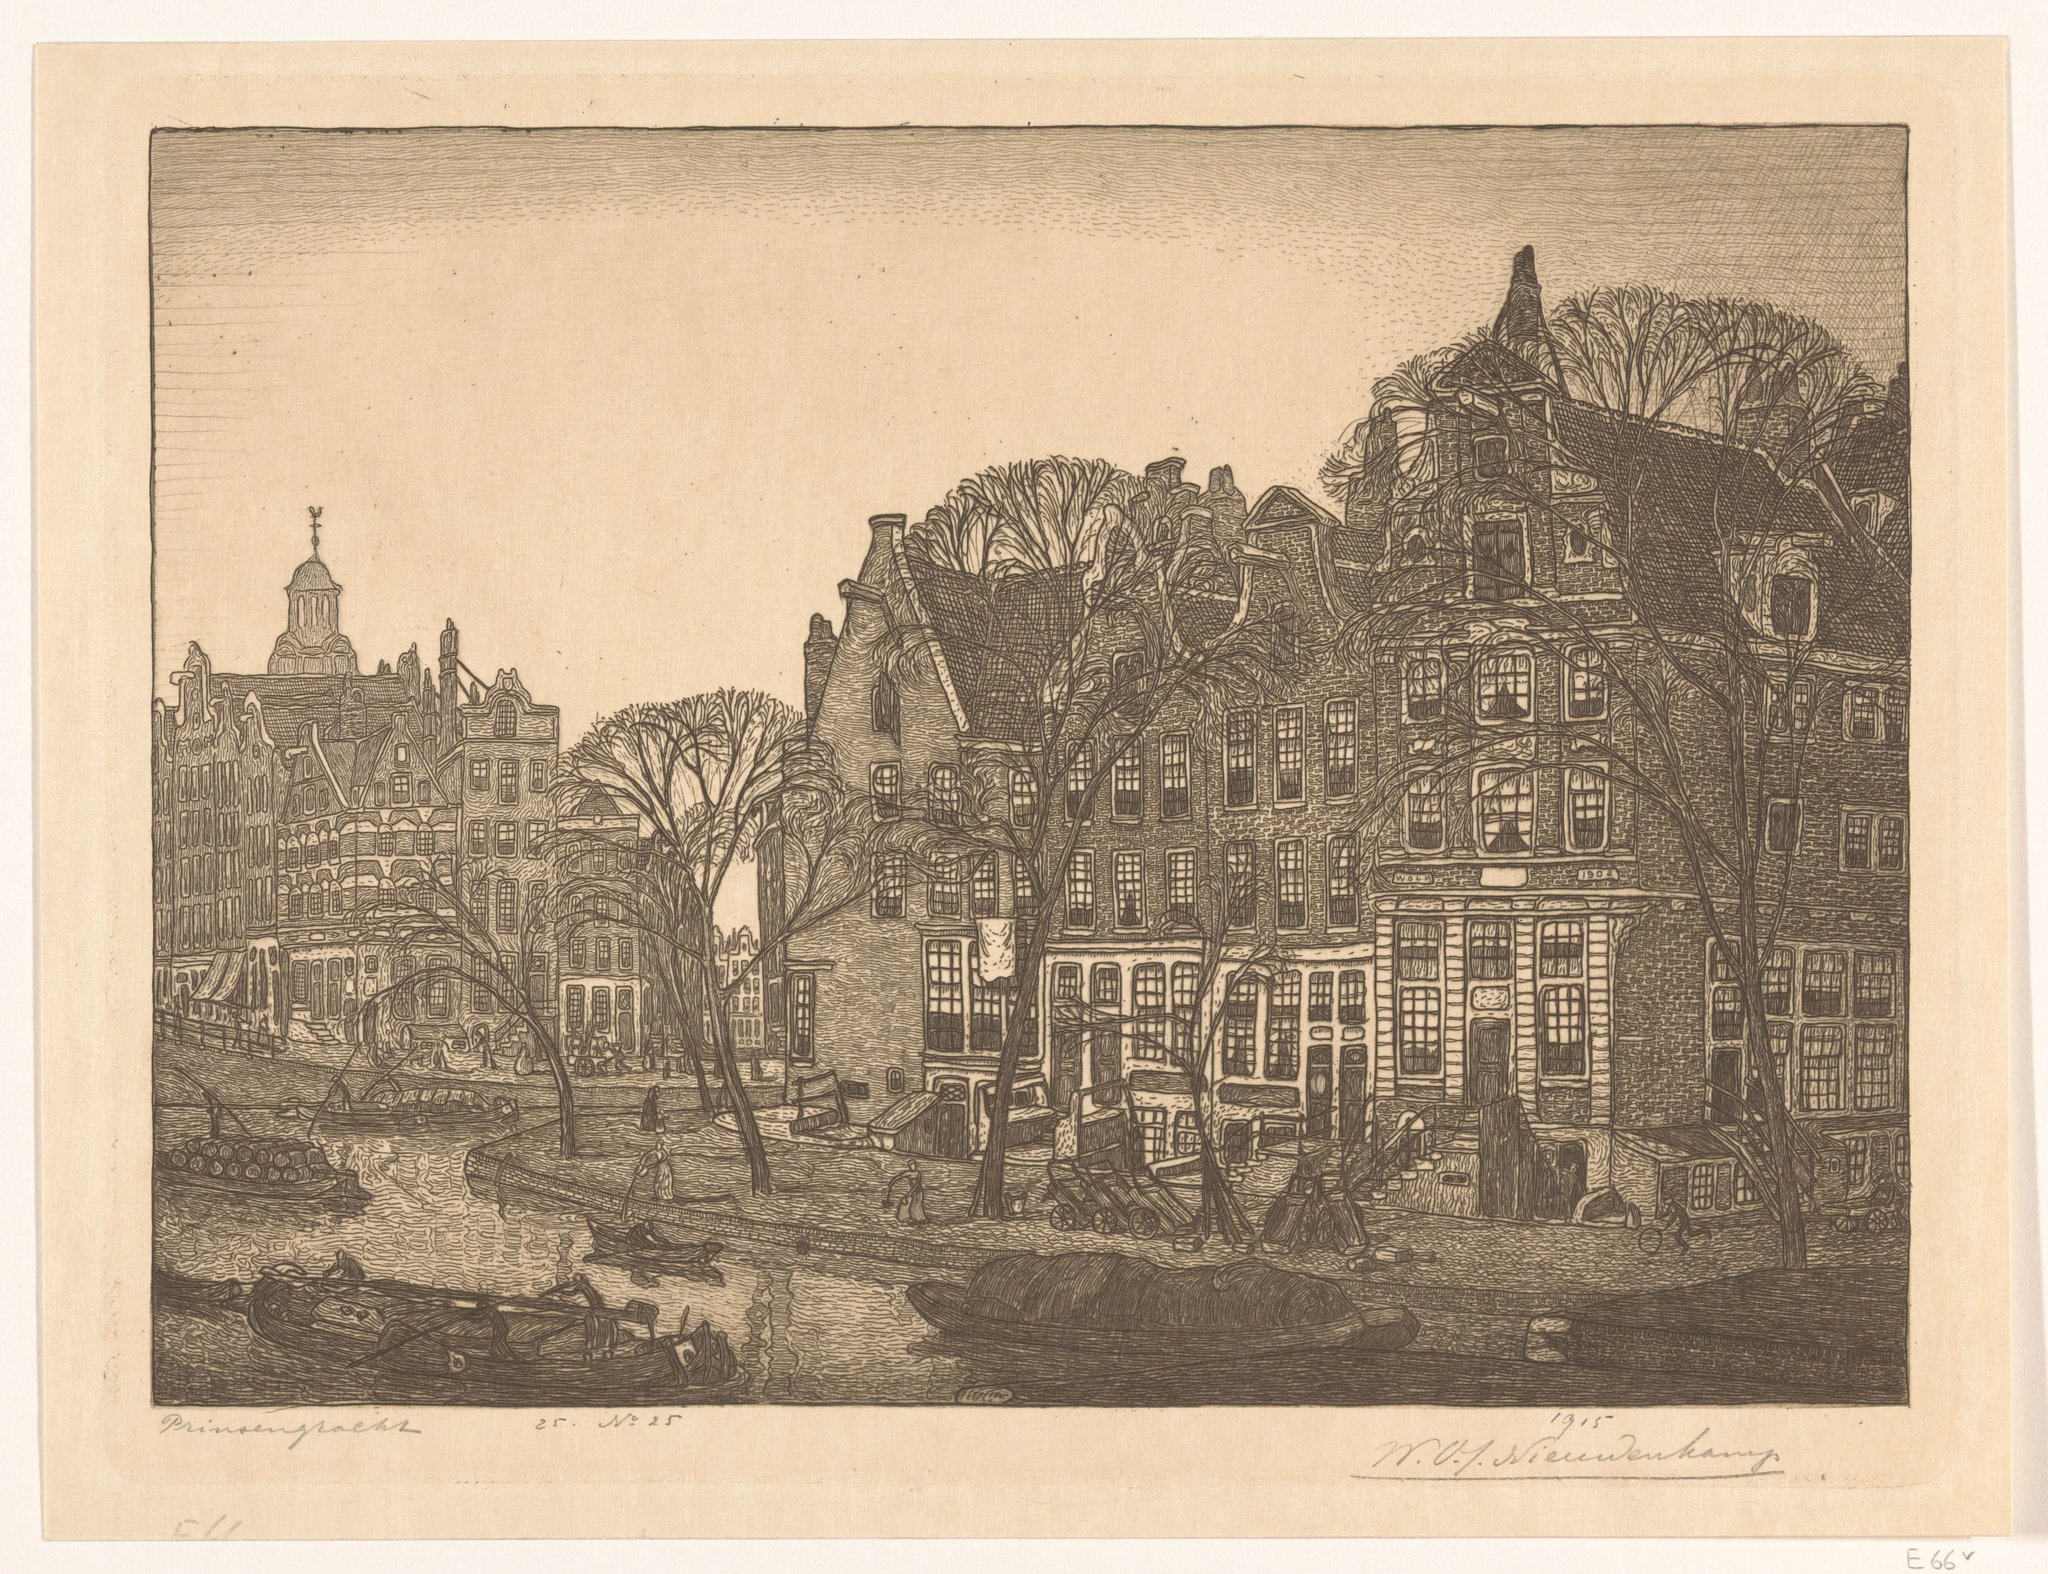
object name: print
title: Prinsengracht, Amsterdam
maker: wijnand otto jan nieuwenkamp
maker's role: draughtsman, print maker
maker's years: 1874-1950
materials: paper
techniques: etching, intaglio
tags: urban housing, canals, waters (in city)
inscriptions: collector's mark: Lugt 2233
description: Op de voorgrond schepen in het water van de gracht. Links op de achtergrond de toren van de Noorderkerk.